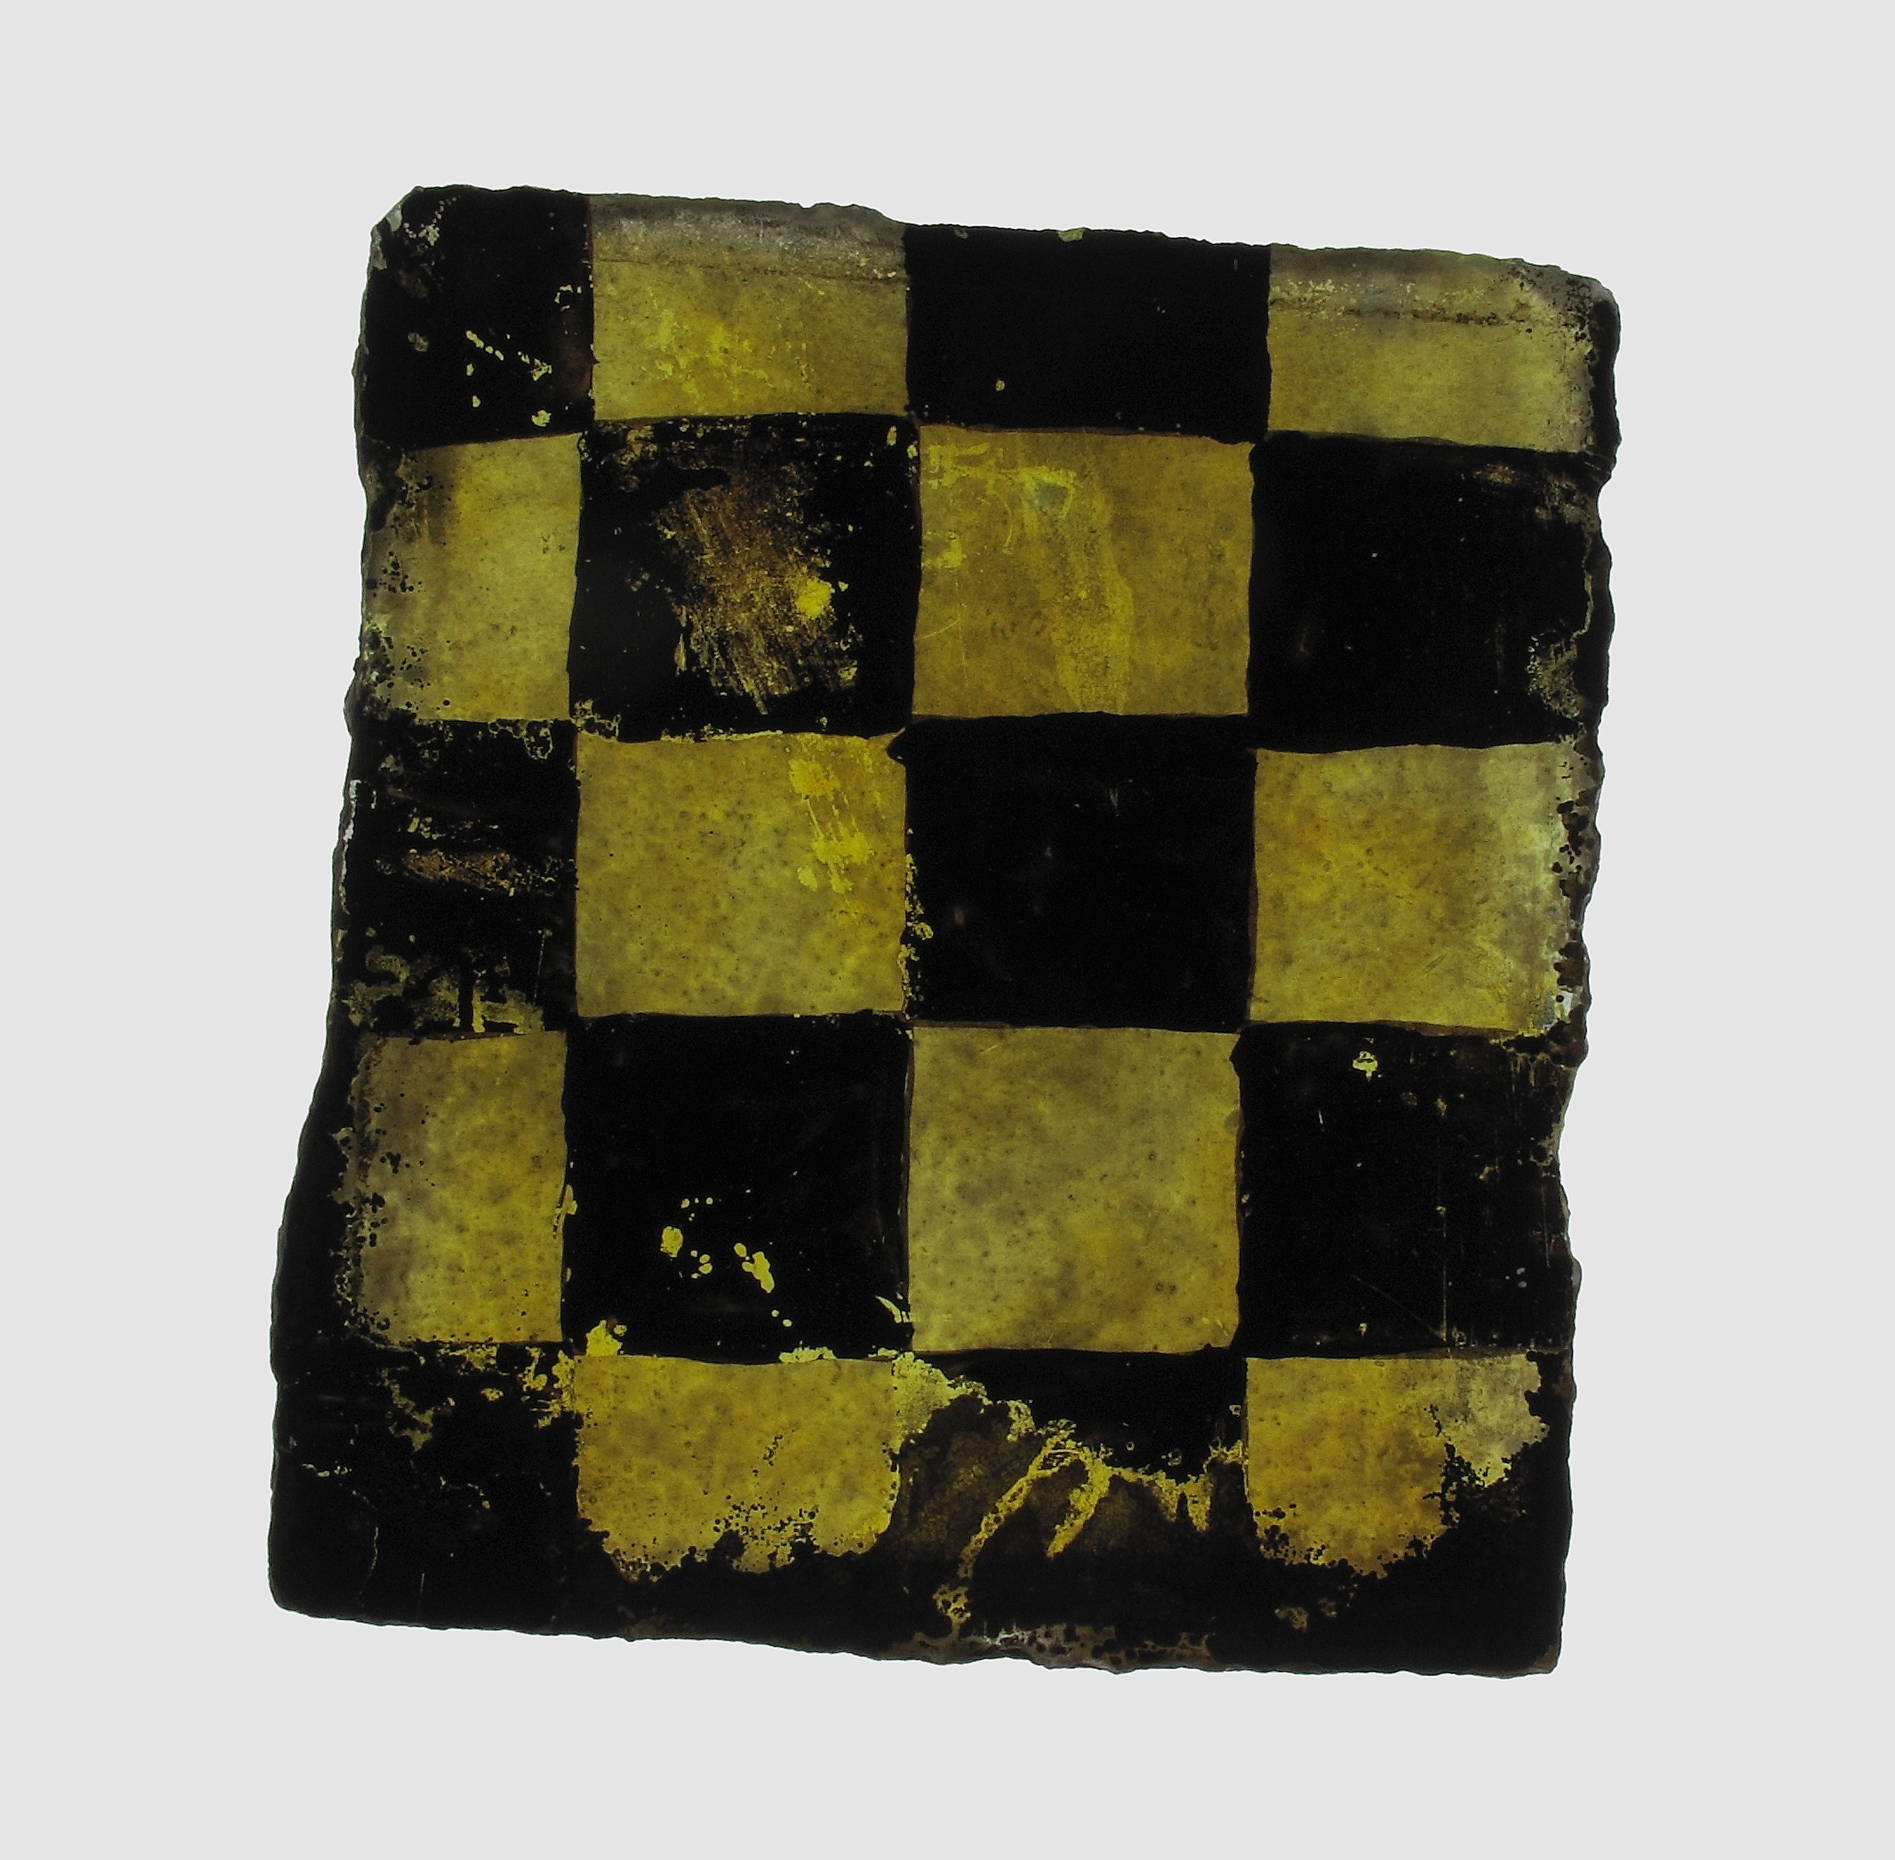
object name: fragment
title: Glass Fragment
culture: european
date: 1401-1500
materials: glass